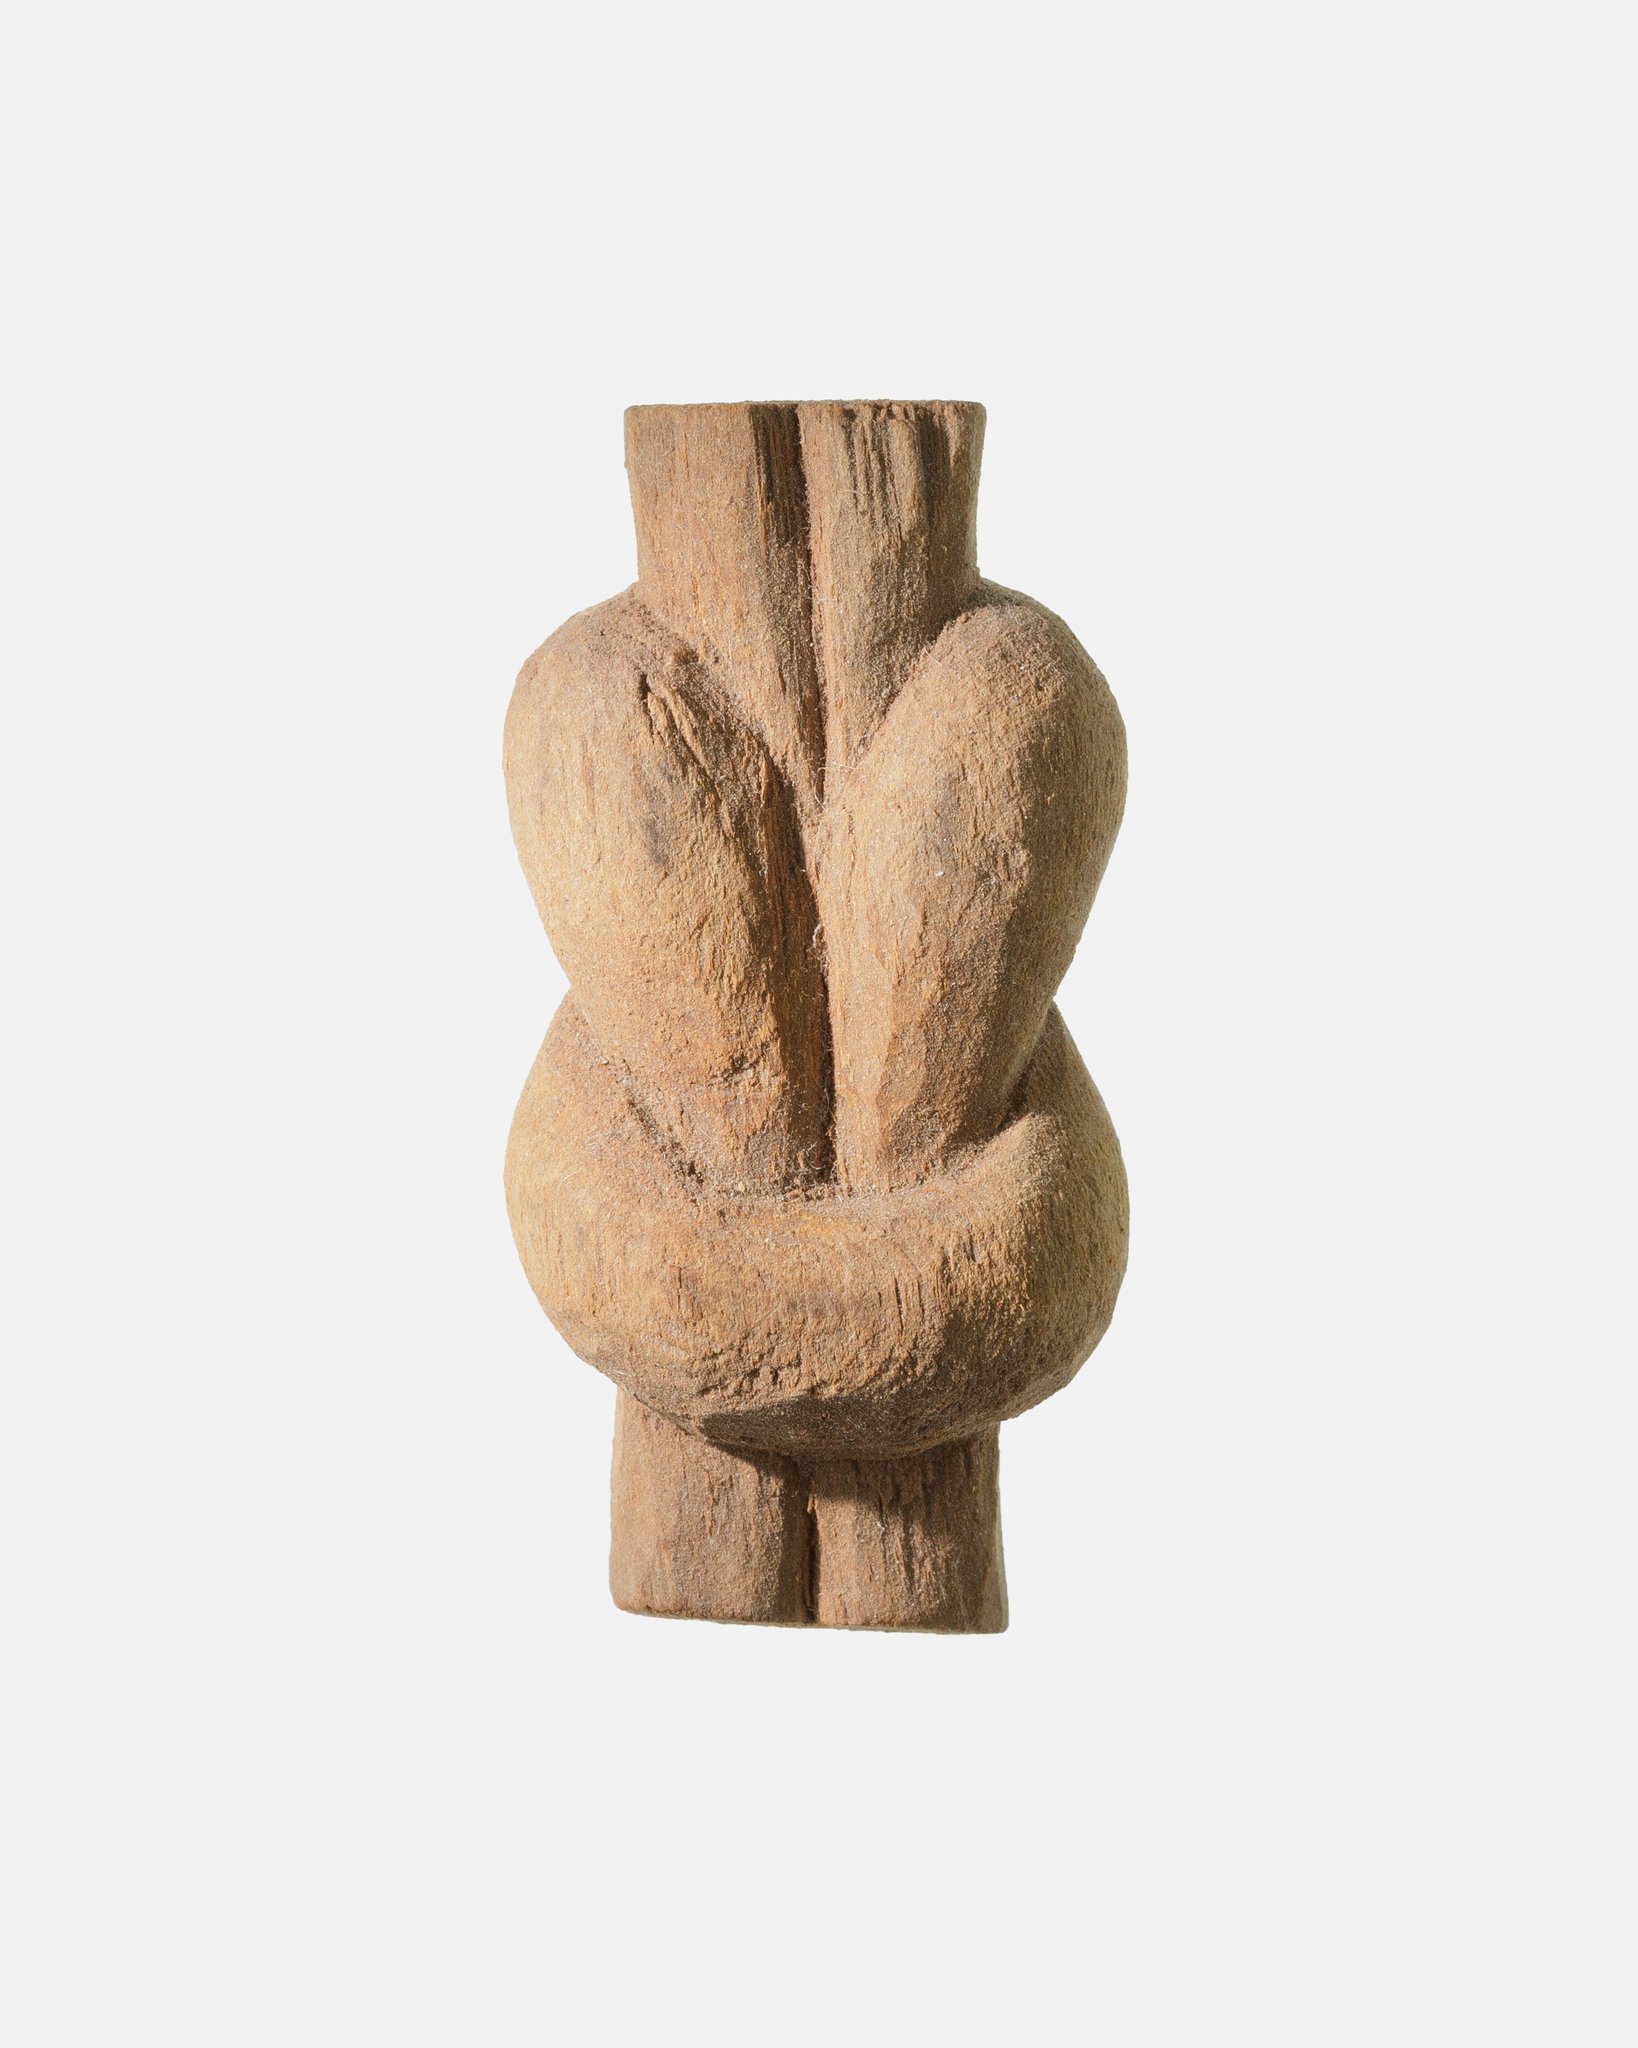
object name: amulet, tjes knot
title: Tjes-Knot Amulet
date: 1479-1458 BCE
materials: wood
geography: egypt